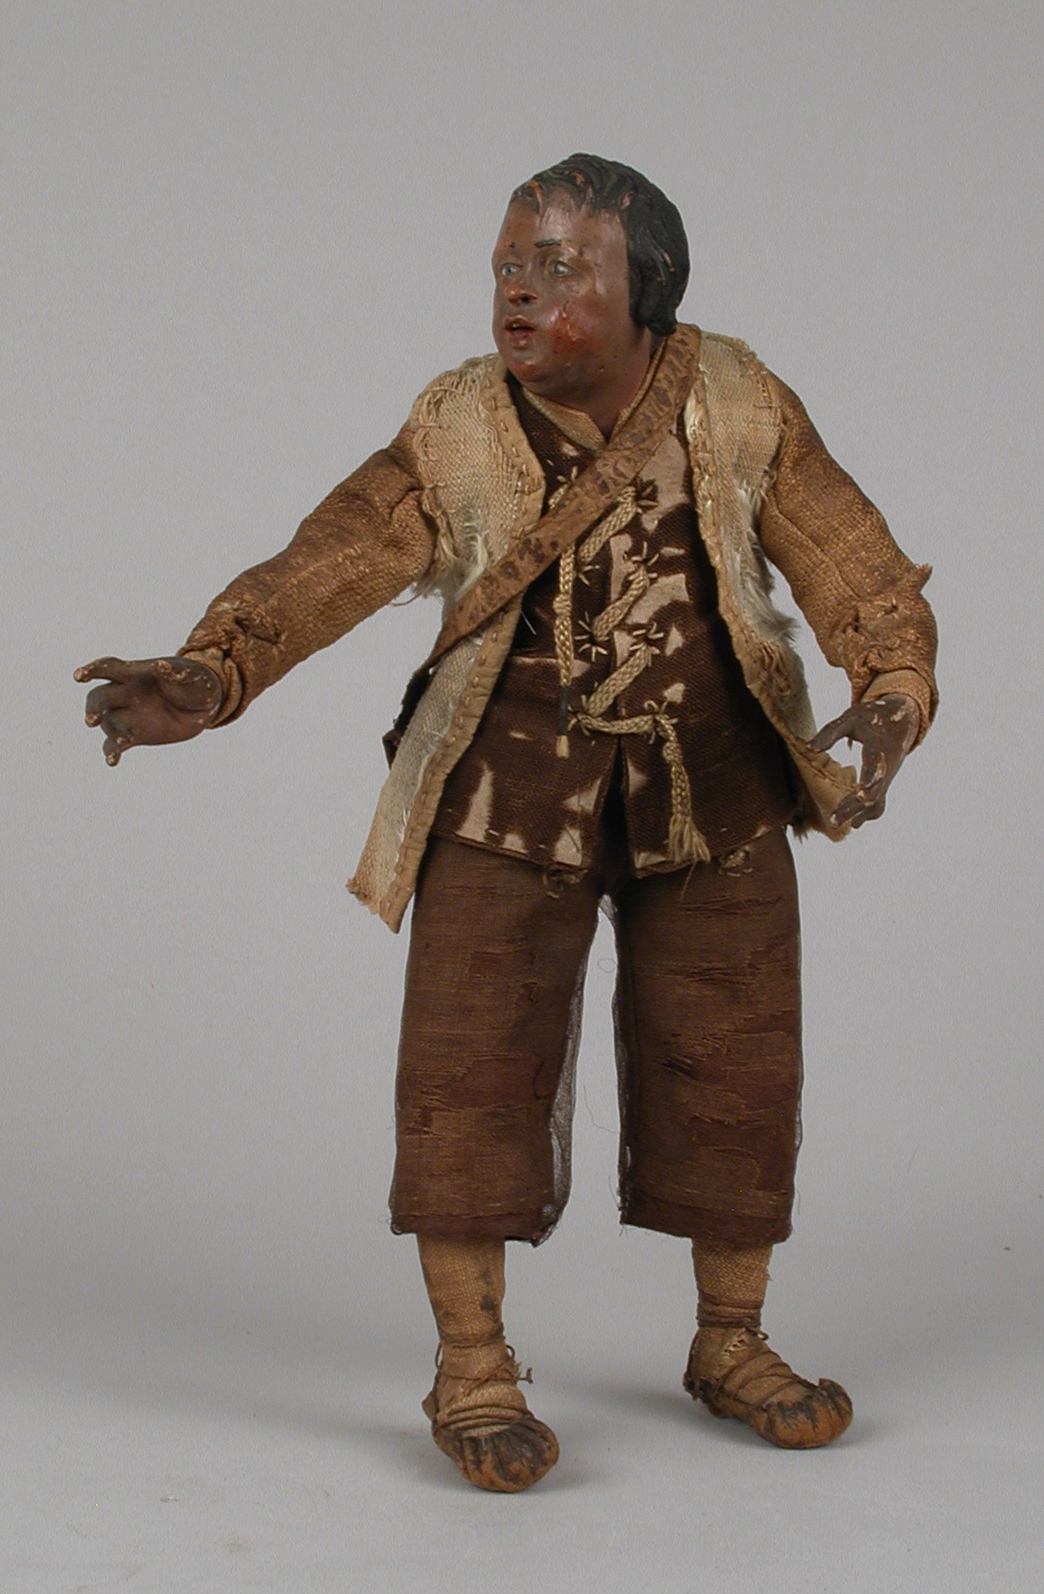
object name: crèche figure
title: Shepherd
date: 1801-1900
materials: textile, leather, linen, terracotta, fiber, metal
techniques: polychrome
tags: men,shepherds